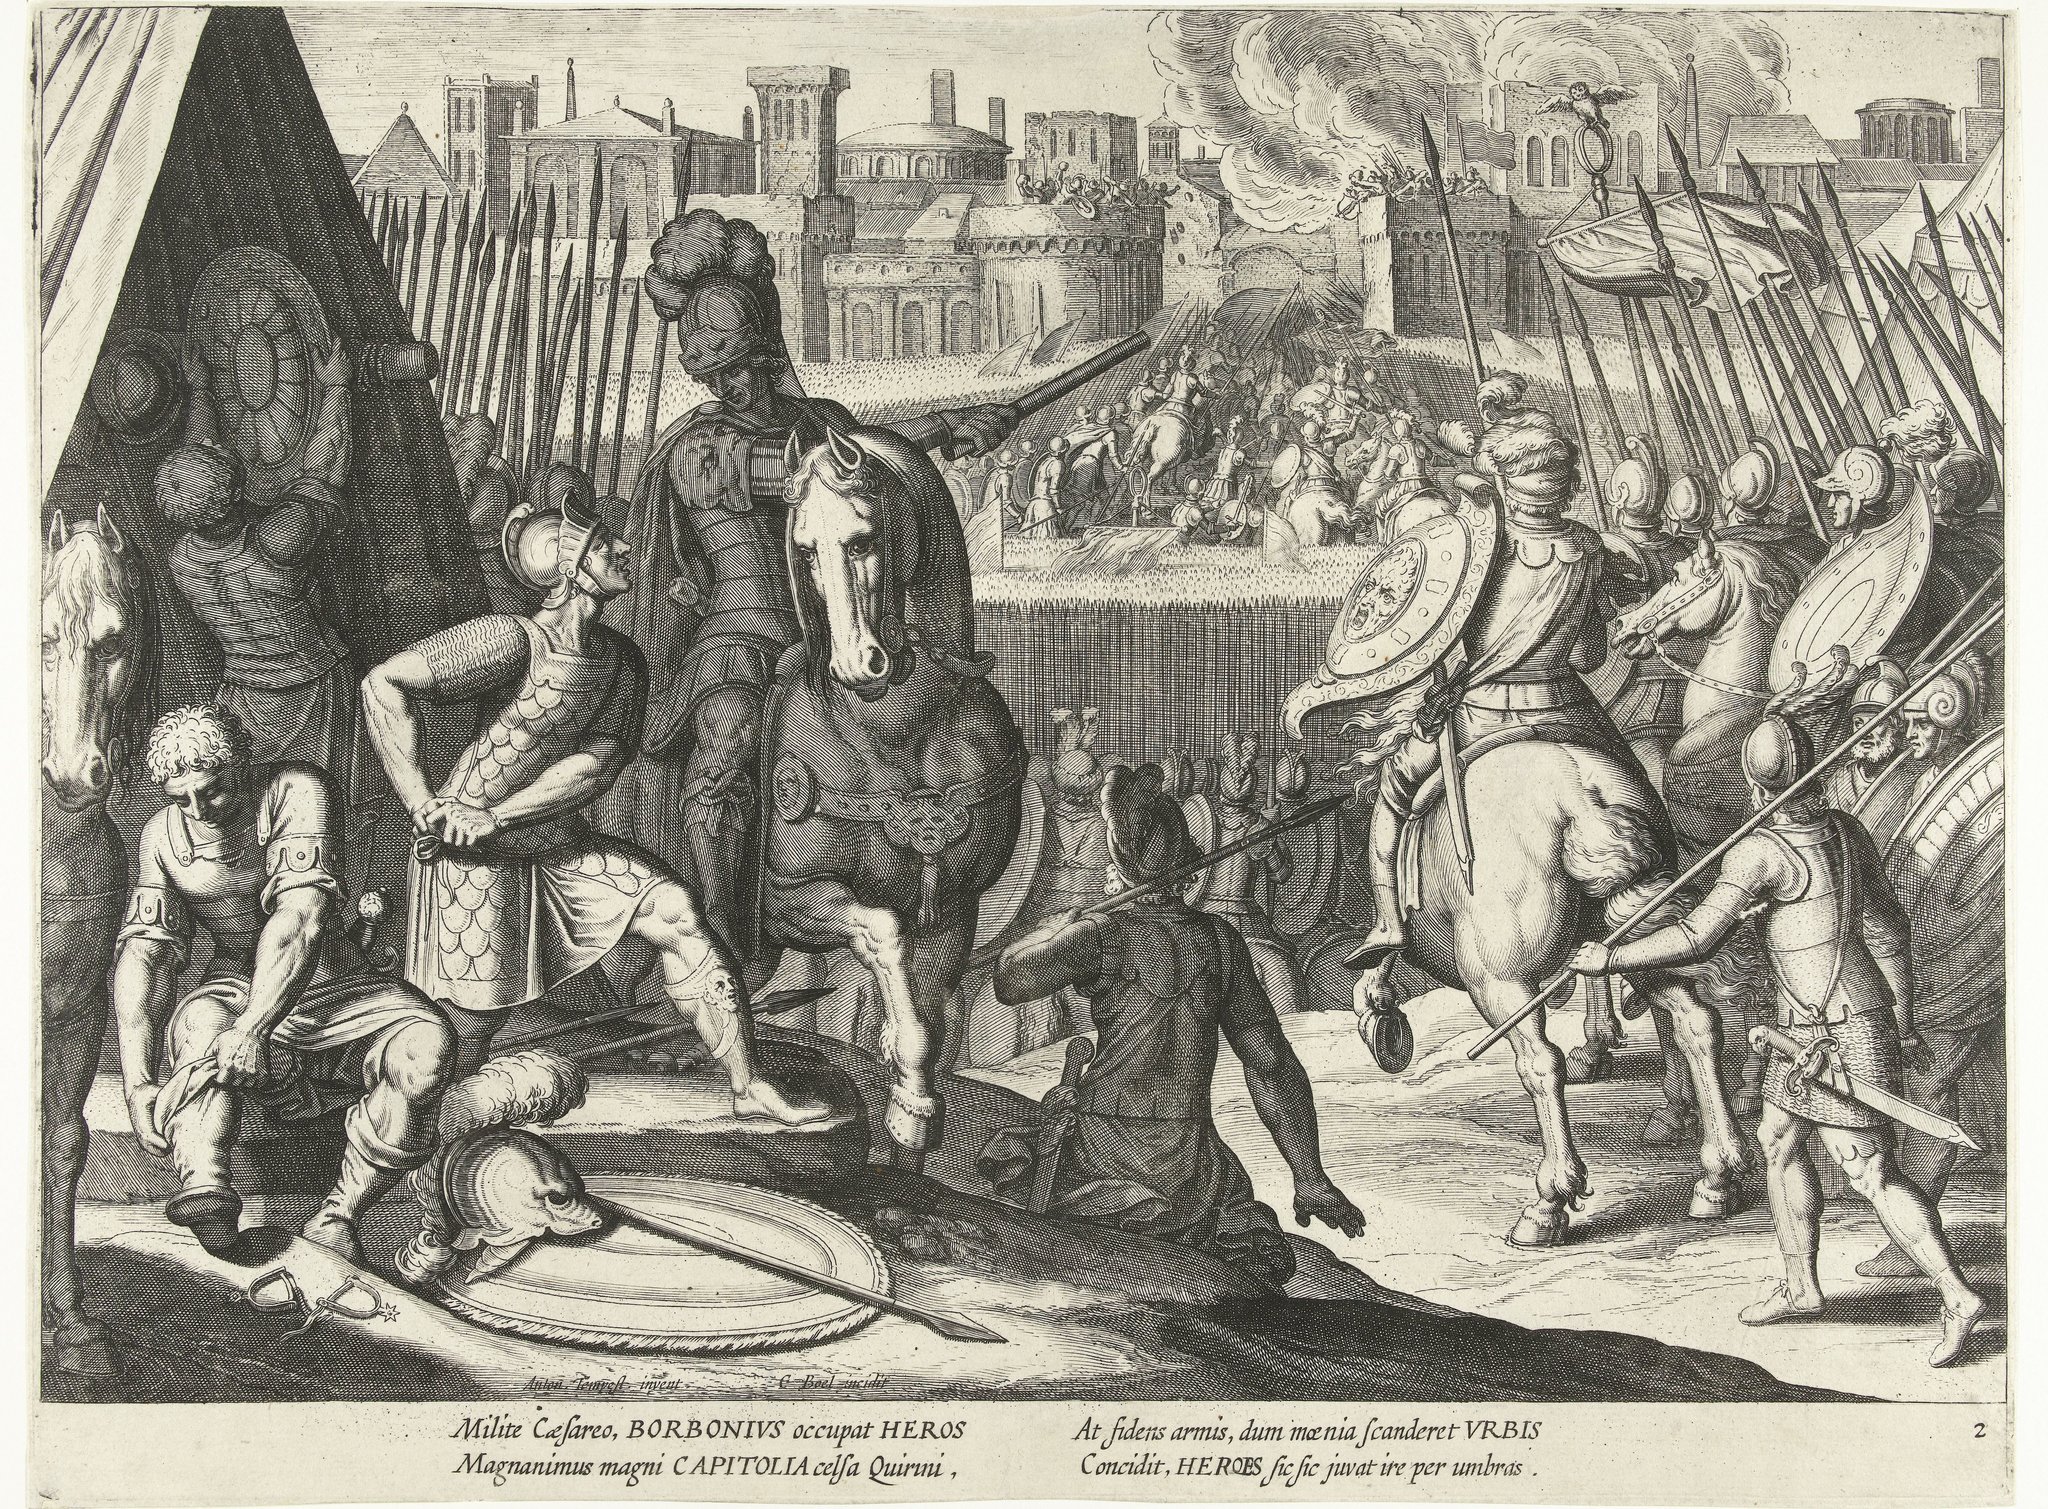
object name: history print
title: Triomfen van Karel V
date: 1614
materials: paper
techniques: engraving, etching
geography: southern netherlands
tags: ghent, charles v (holy roman emperor and king of spain), battle, fighting in general, rome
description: Karel V valt met zijn leger Rome binnen. Hij zit op een paard en wijst met zijn commandostaf naar de stad. Naast hem kleden soldaten zich aan. Op de achtergrond vallen de troepen al de stad binnen. Met onderschrift van vier regels in het Latijn. Deze prent is onderdeel van een reeks van acht prenten, elk een triomf van Karel V voorstellende.